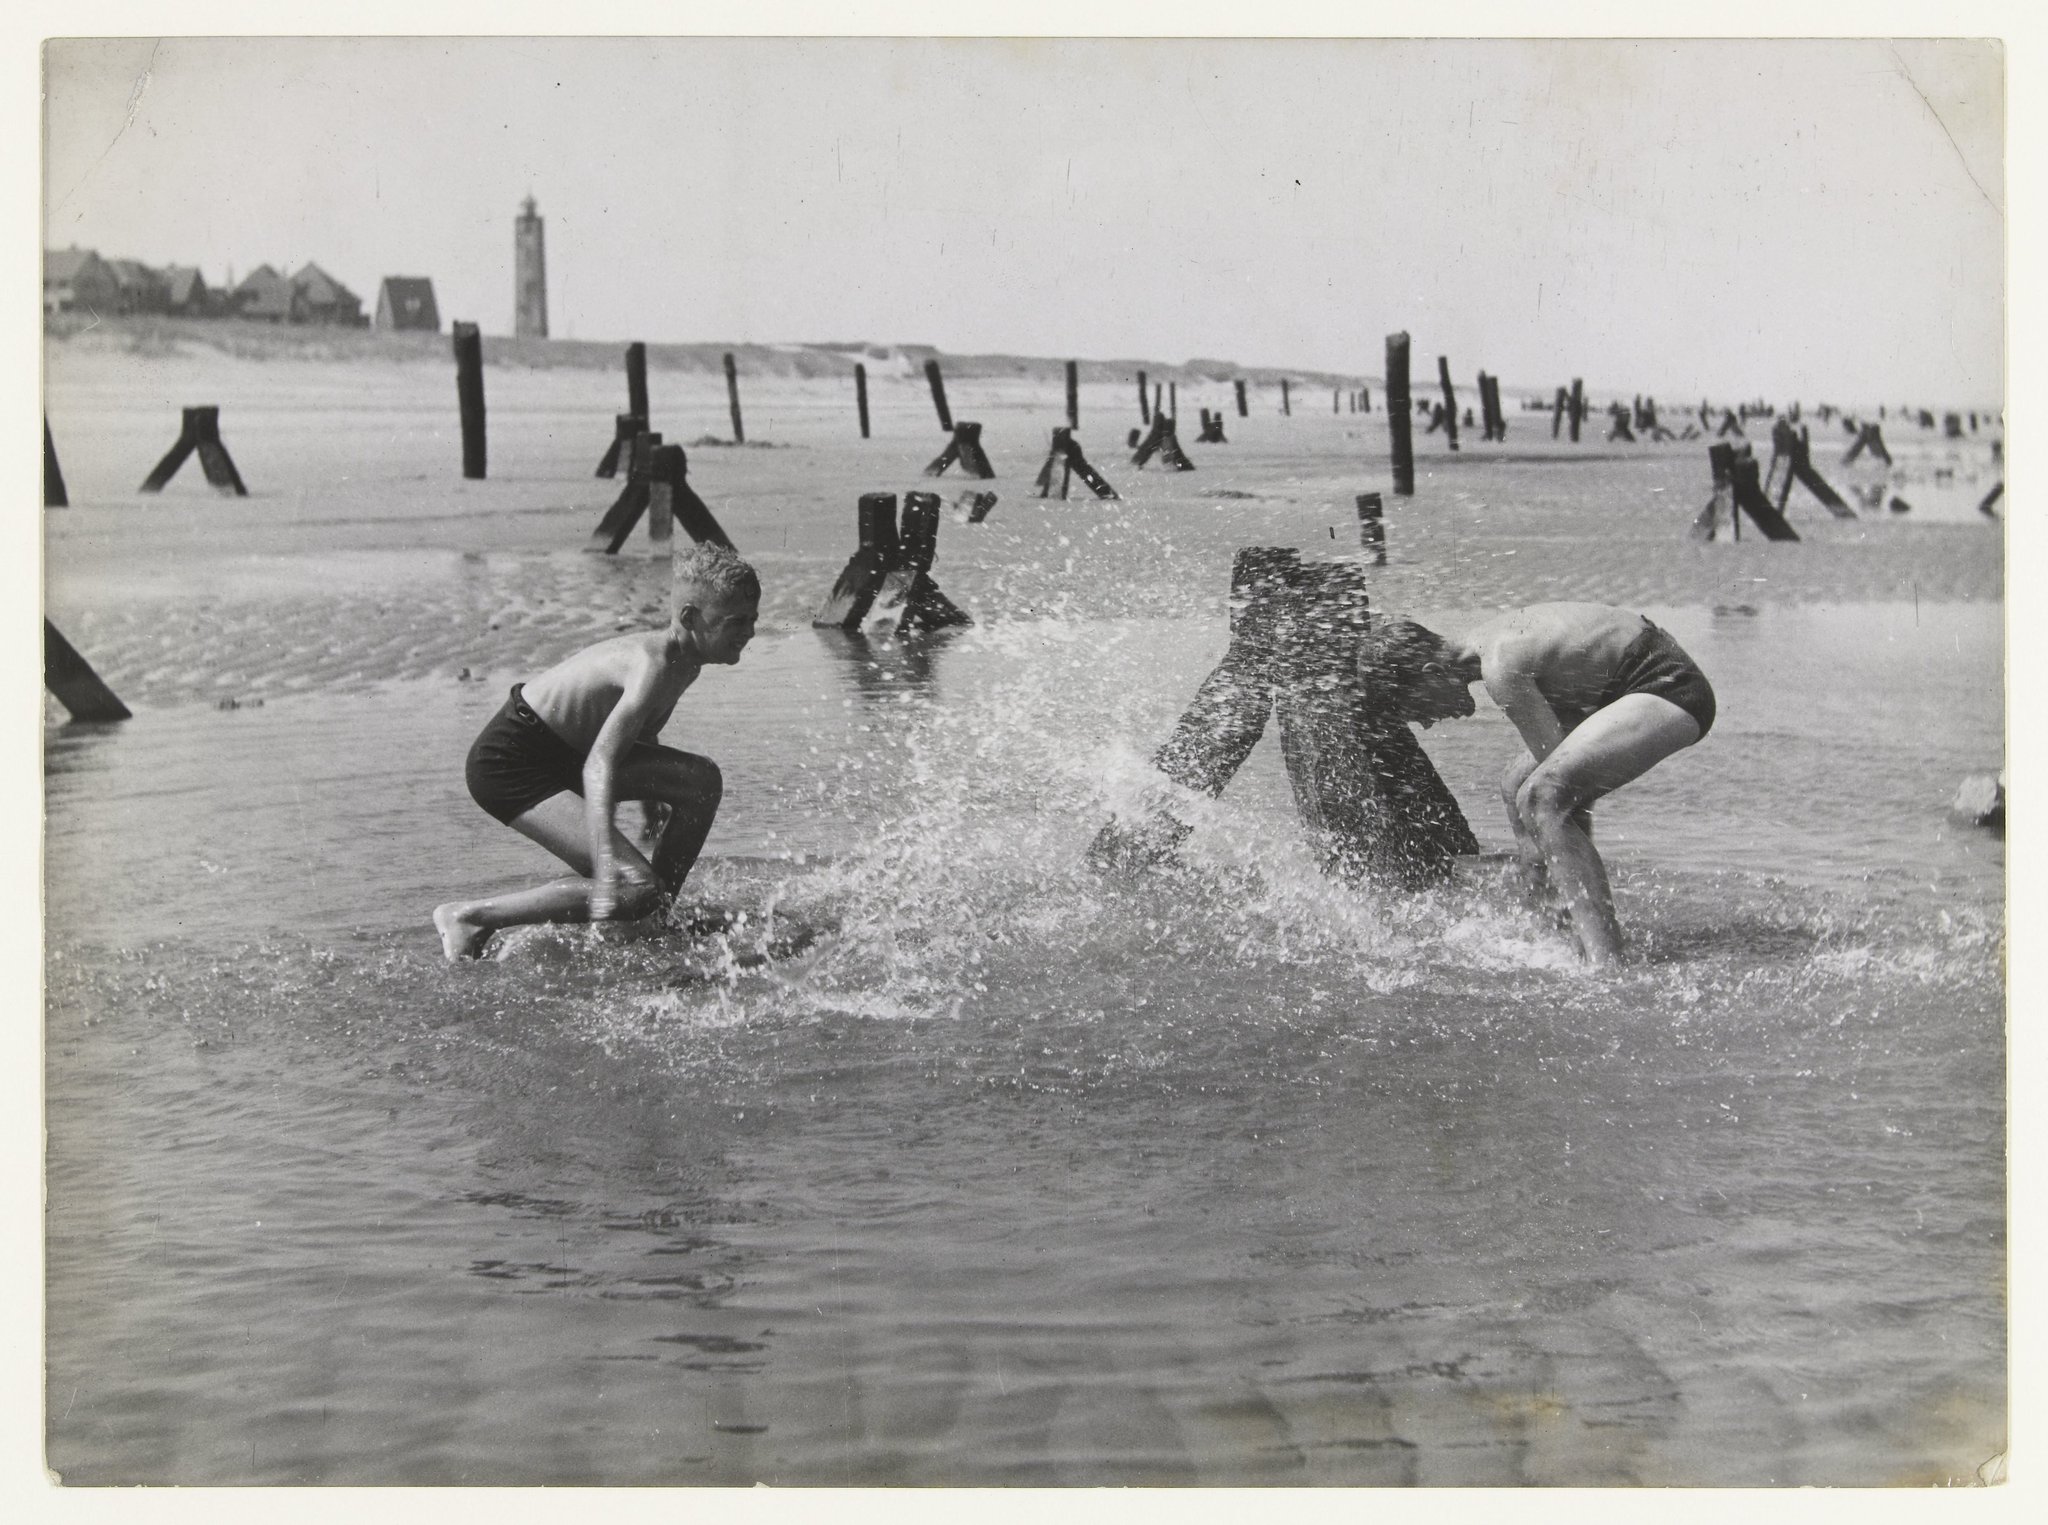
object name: documentary photograph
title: Twee jongens spelen op het strand van Noordwijk in de zee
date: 1908-1945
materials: photographic support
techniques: photography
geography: noordwijk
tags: noordwijk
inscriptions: number: ‘4965’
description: Twee jongens zijn aan het spetteren met water in de zee bij Noordwijk. Met op het strand overblijfselen uit WOII de zogenaamde 'rommelasperges' of anti-tankversperringen, waarmee de Duitsers uit angst voor een geallieerde luchtlandingen de weg probeerden te versperren. Op de achtergrond ligt Noordwijk met vuurtoren.